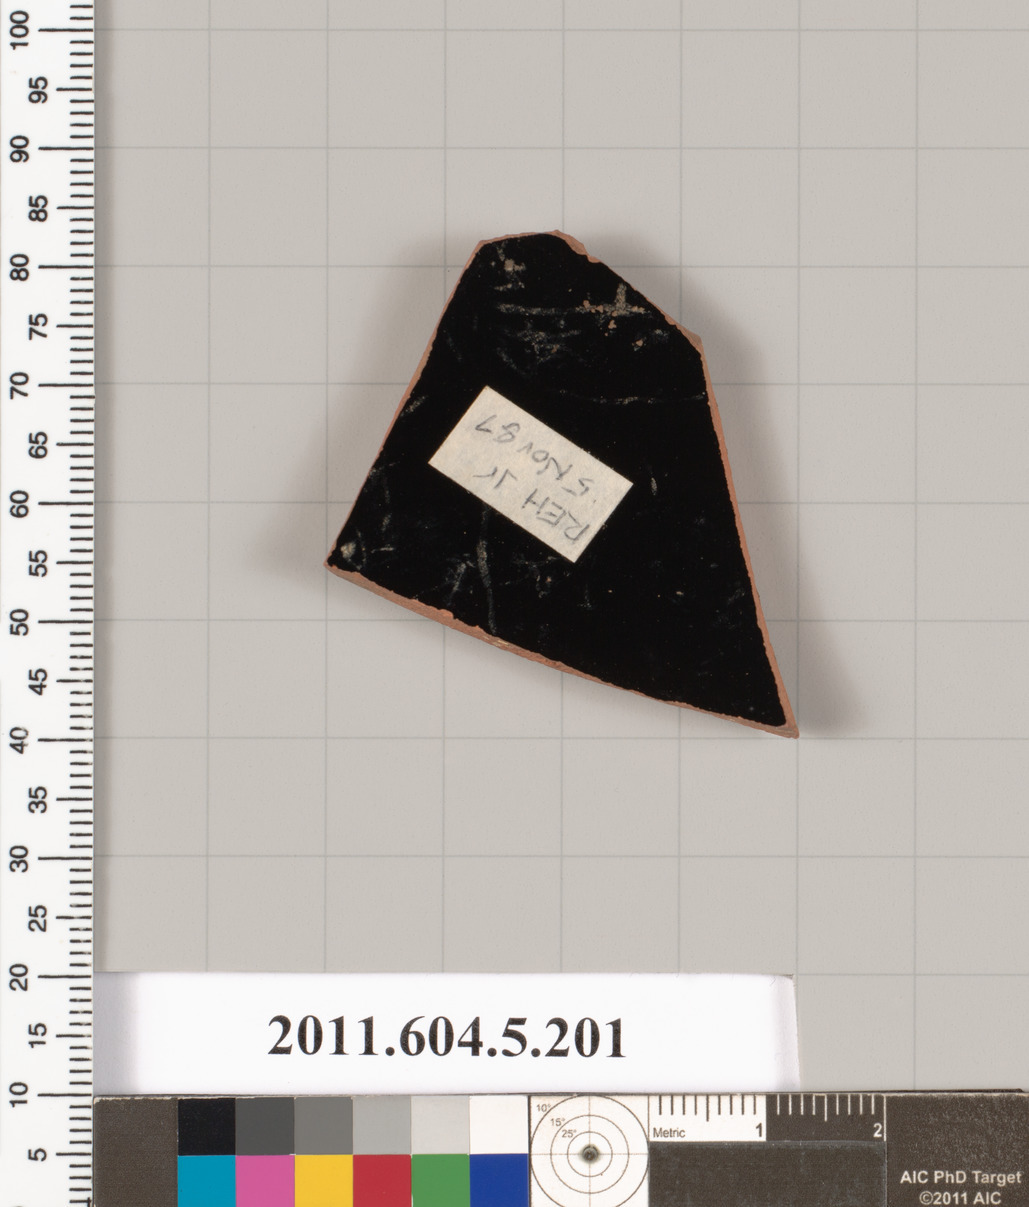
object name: kylix fragment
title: Terracotta fragment of a kylix (drinking cup)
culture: greek, attic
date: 600-401 BCE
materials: terracotta